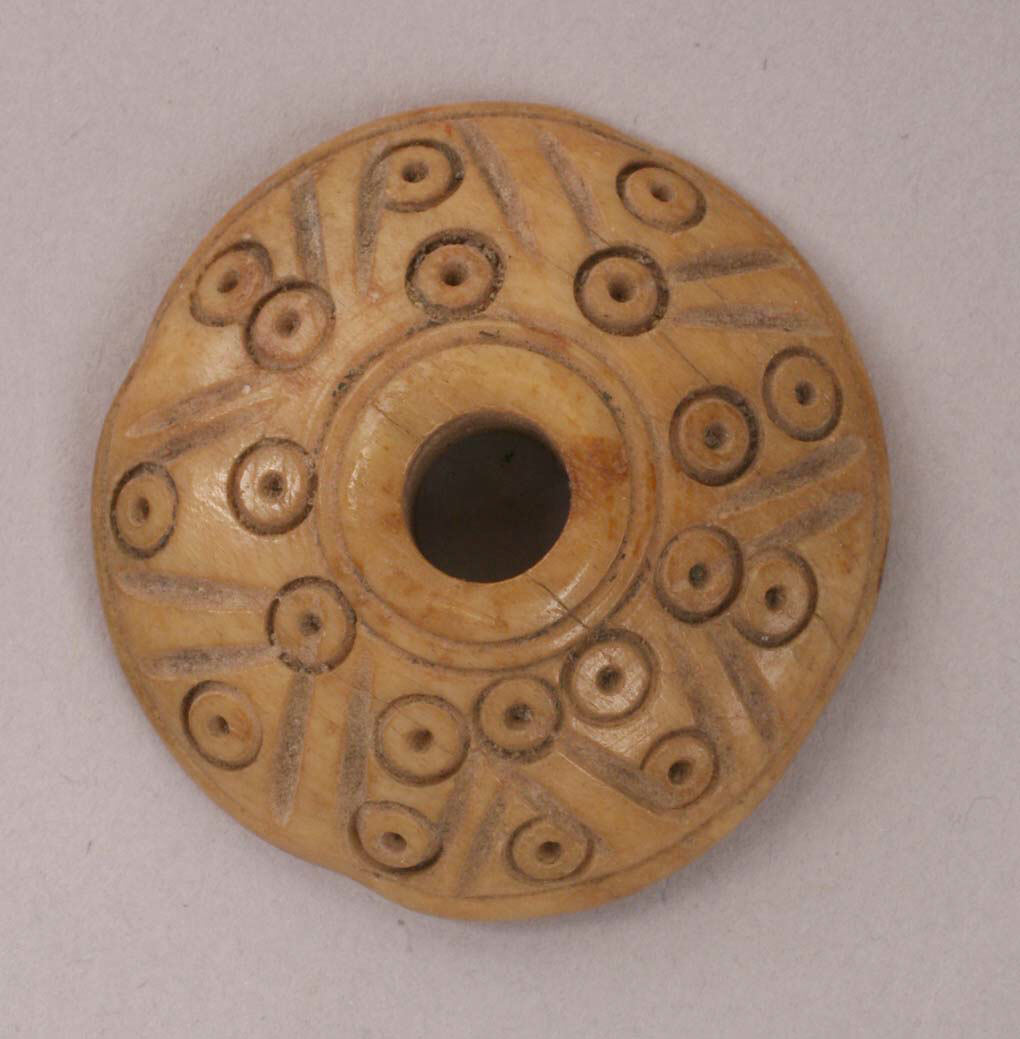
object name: button or spindle whorl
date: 201-700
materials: bone, paint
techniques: incising, inlay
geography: egypt